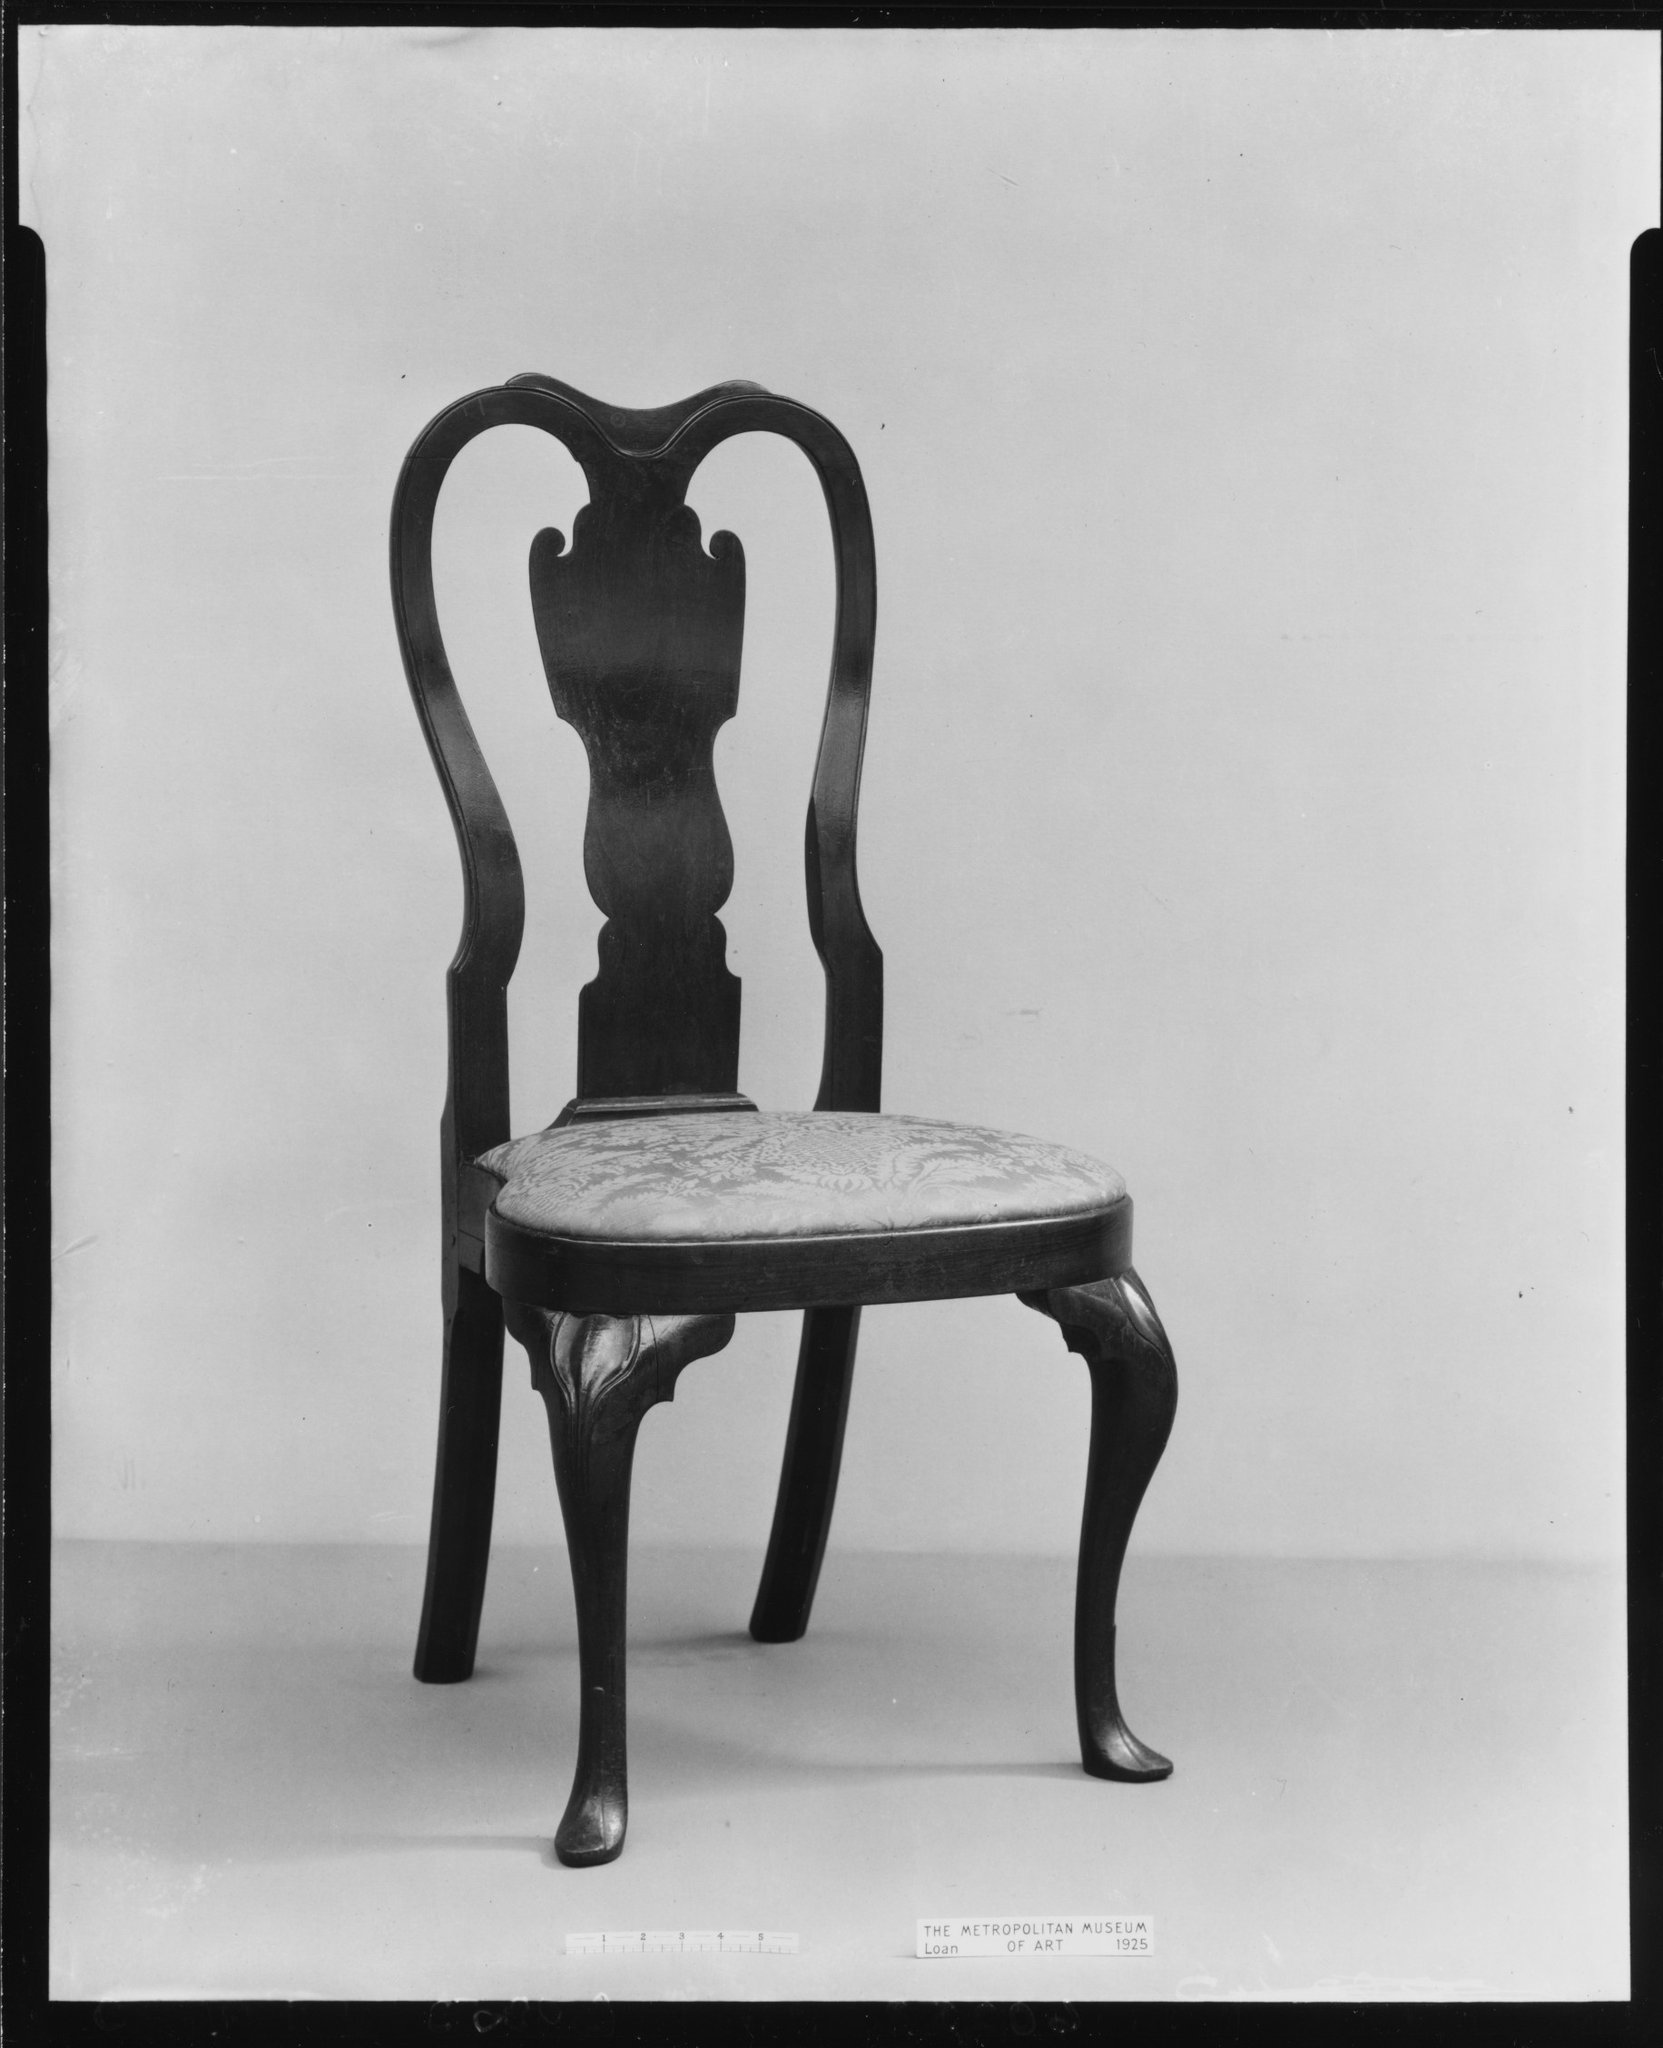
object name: side chair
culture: american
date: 1740-1760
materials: wood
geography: united states